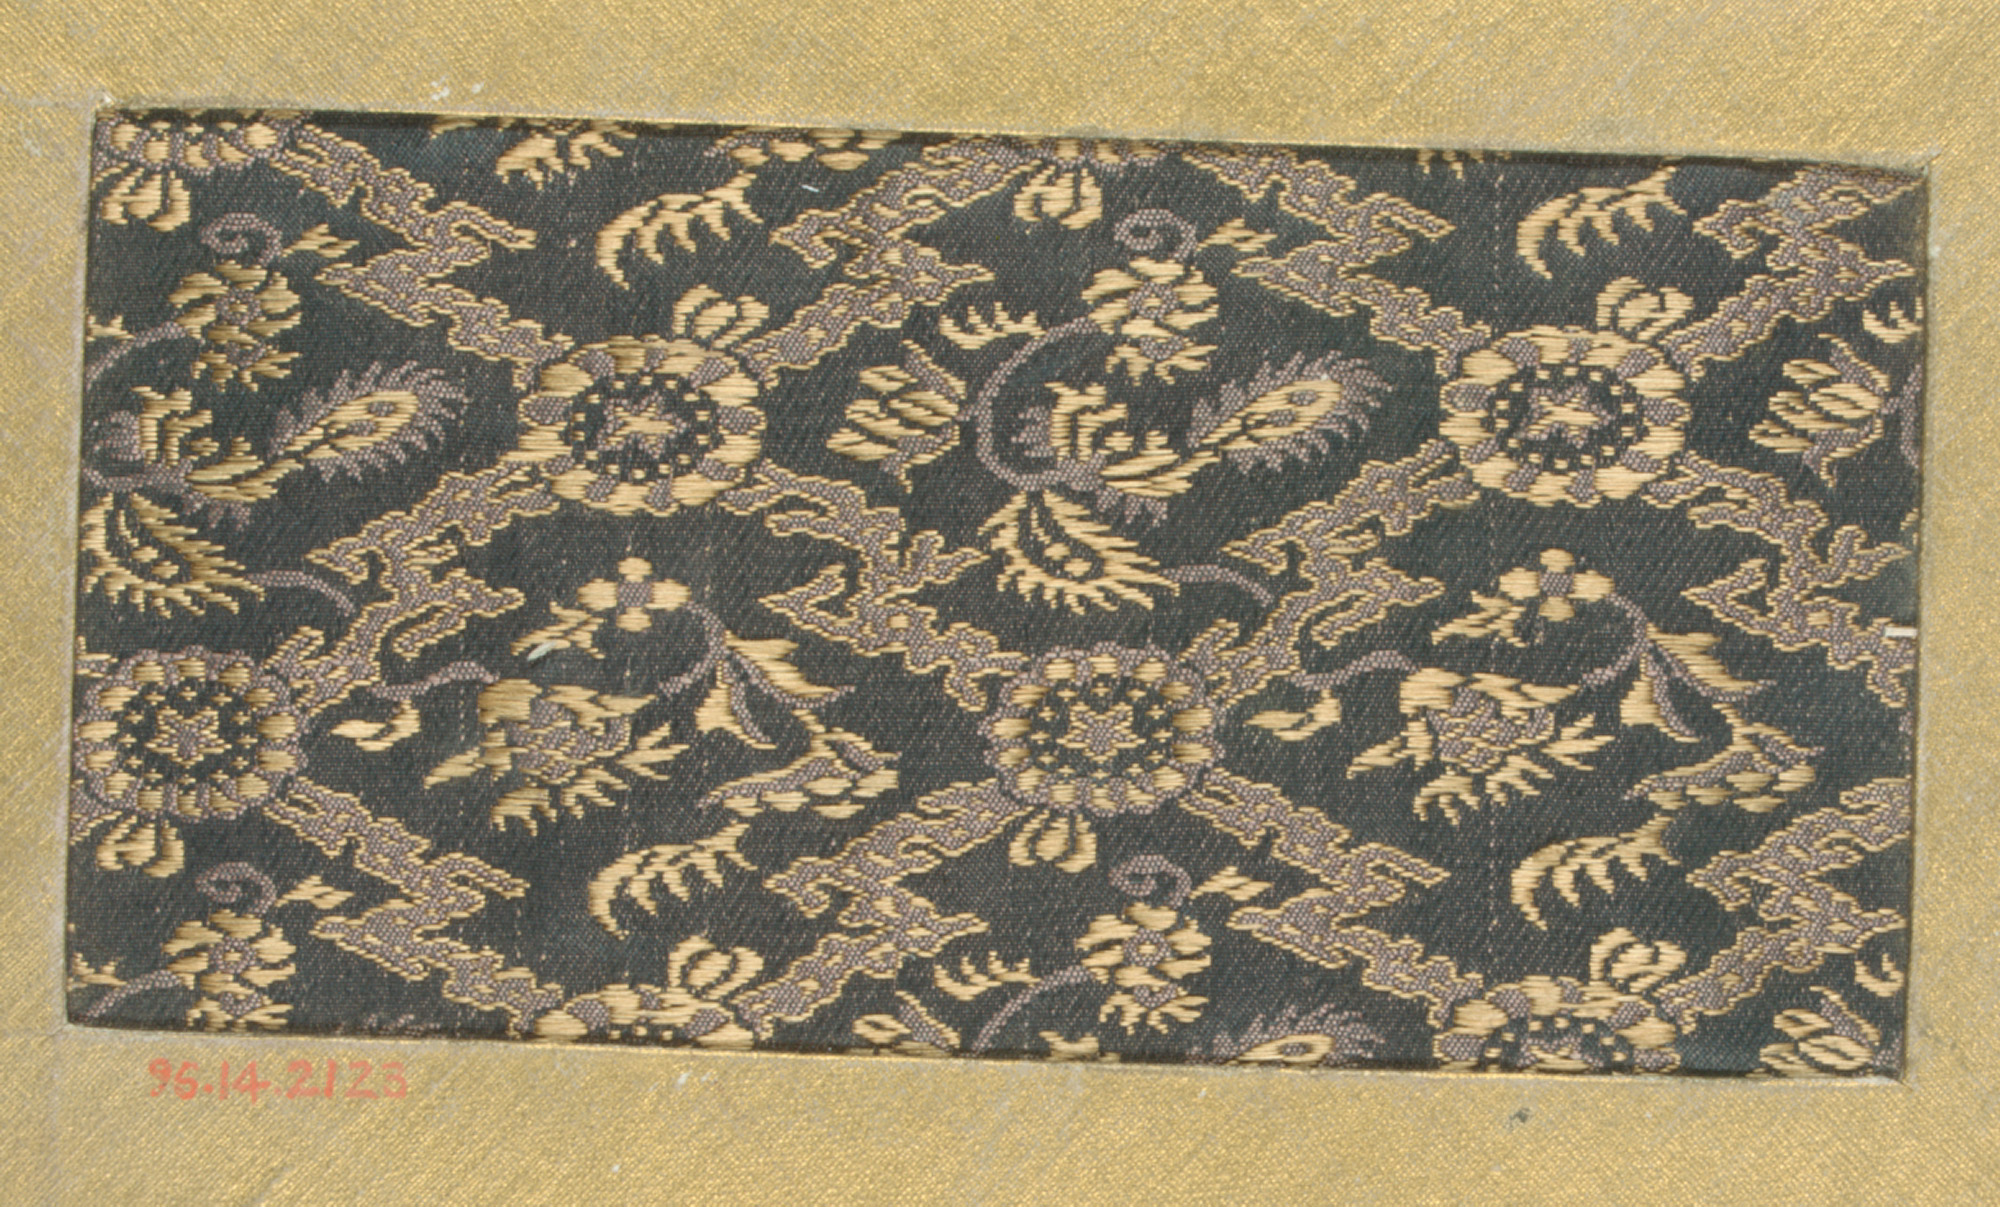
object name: piece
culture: japanese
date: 1701-1900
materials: silk